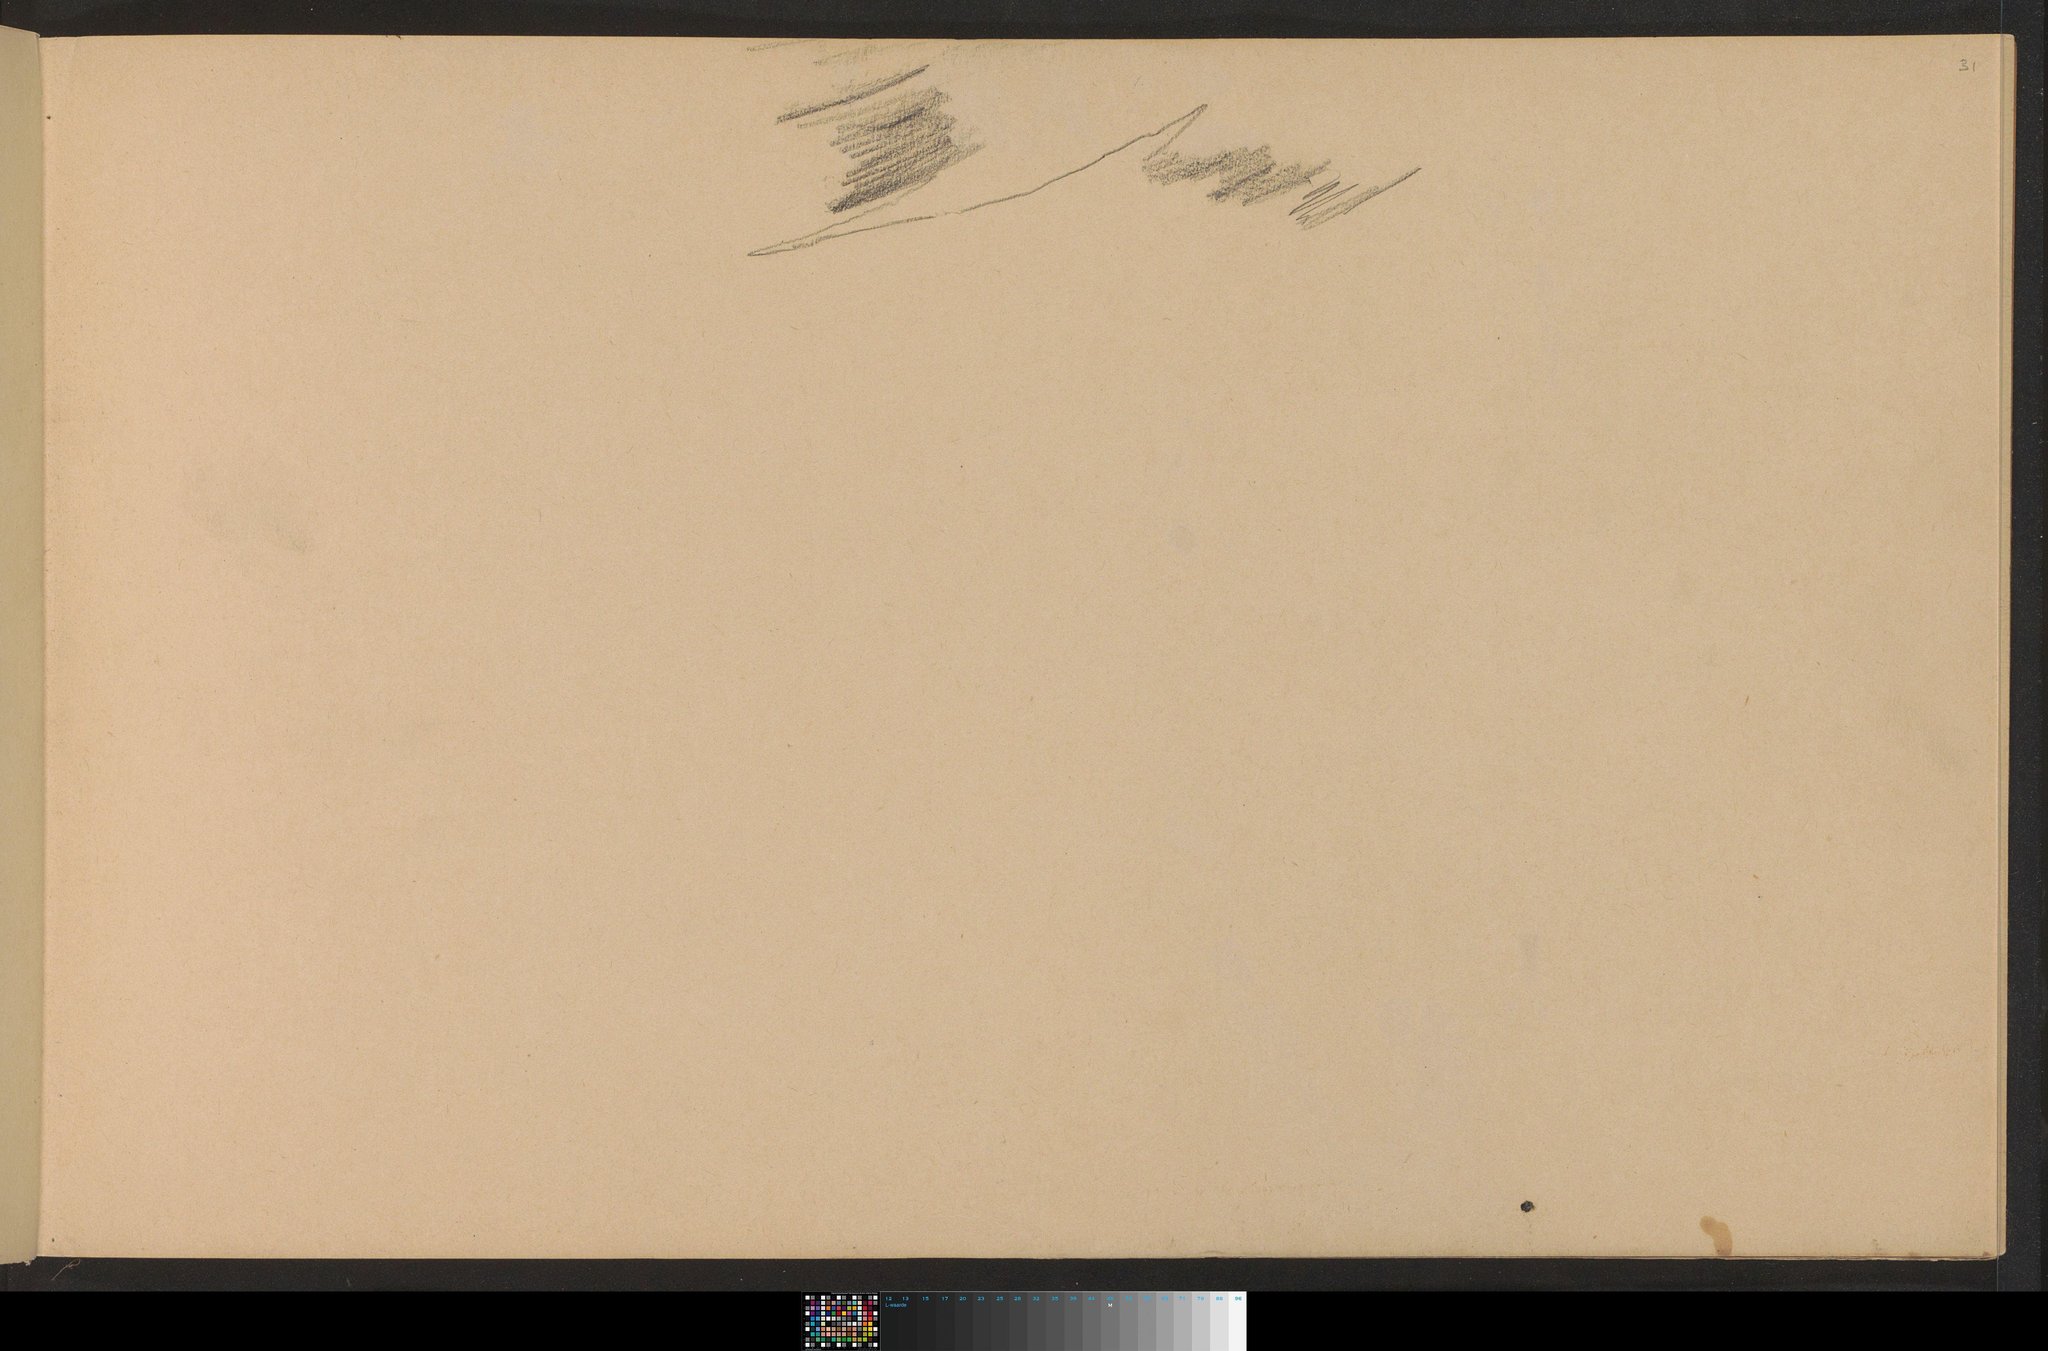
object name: sketchbook leaf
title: Studie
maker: willem witsen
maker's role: draughtsman, painter, print maker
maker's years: 1860-1923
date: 1897-1910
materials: chalk, paper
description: Pagina 31 uit een schetsboek met 19 bladen.